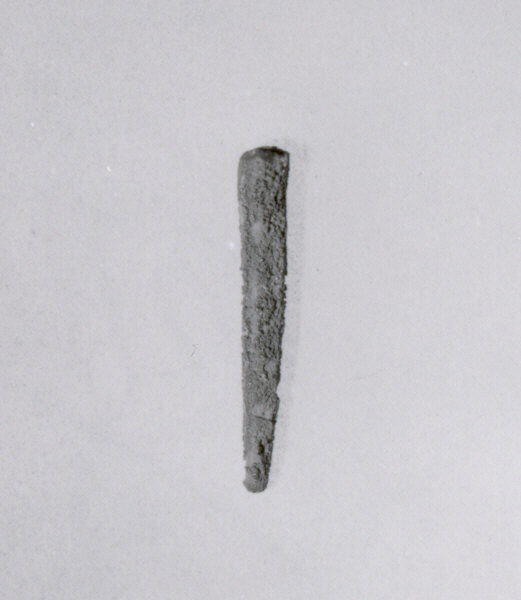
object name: rivet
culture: achaemenid or seleucid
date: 500-168 BCE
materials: silver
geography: iran